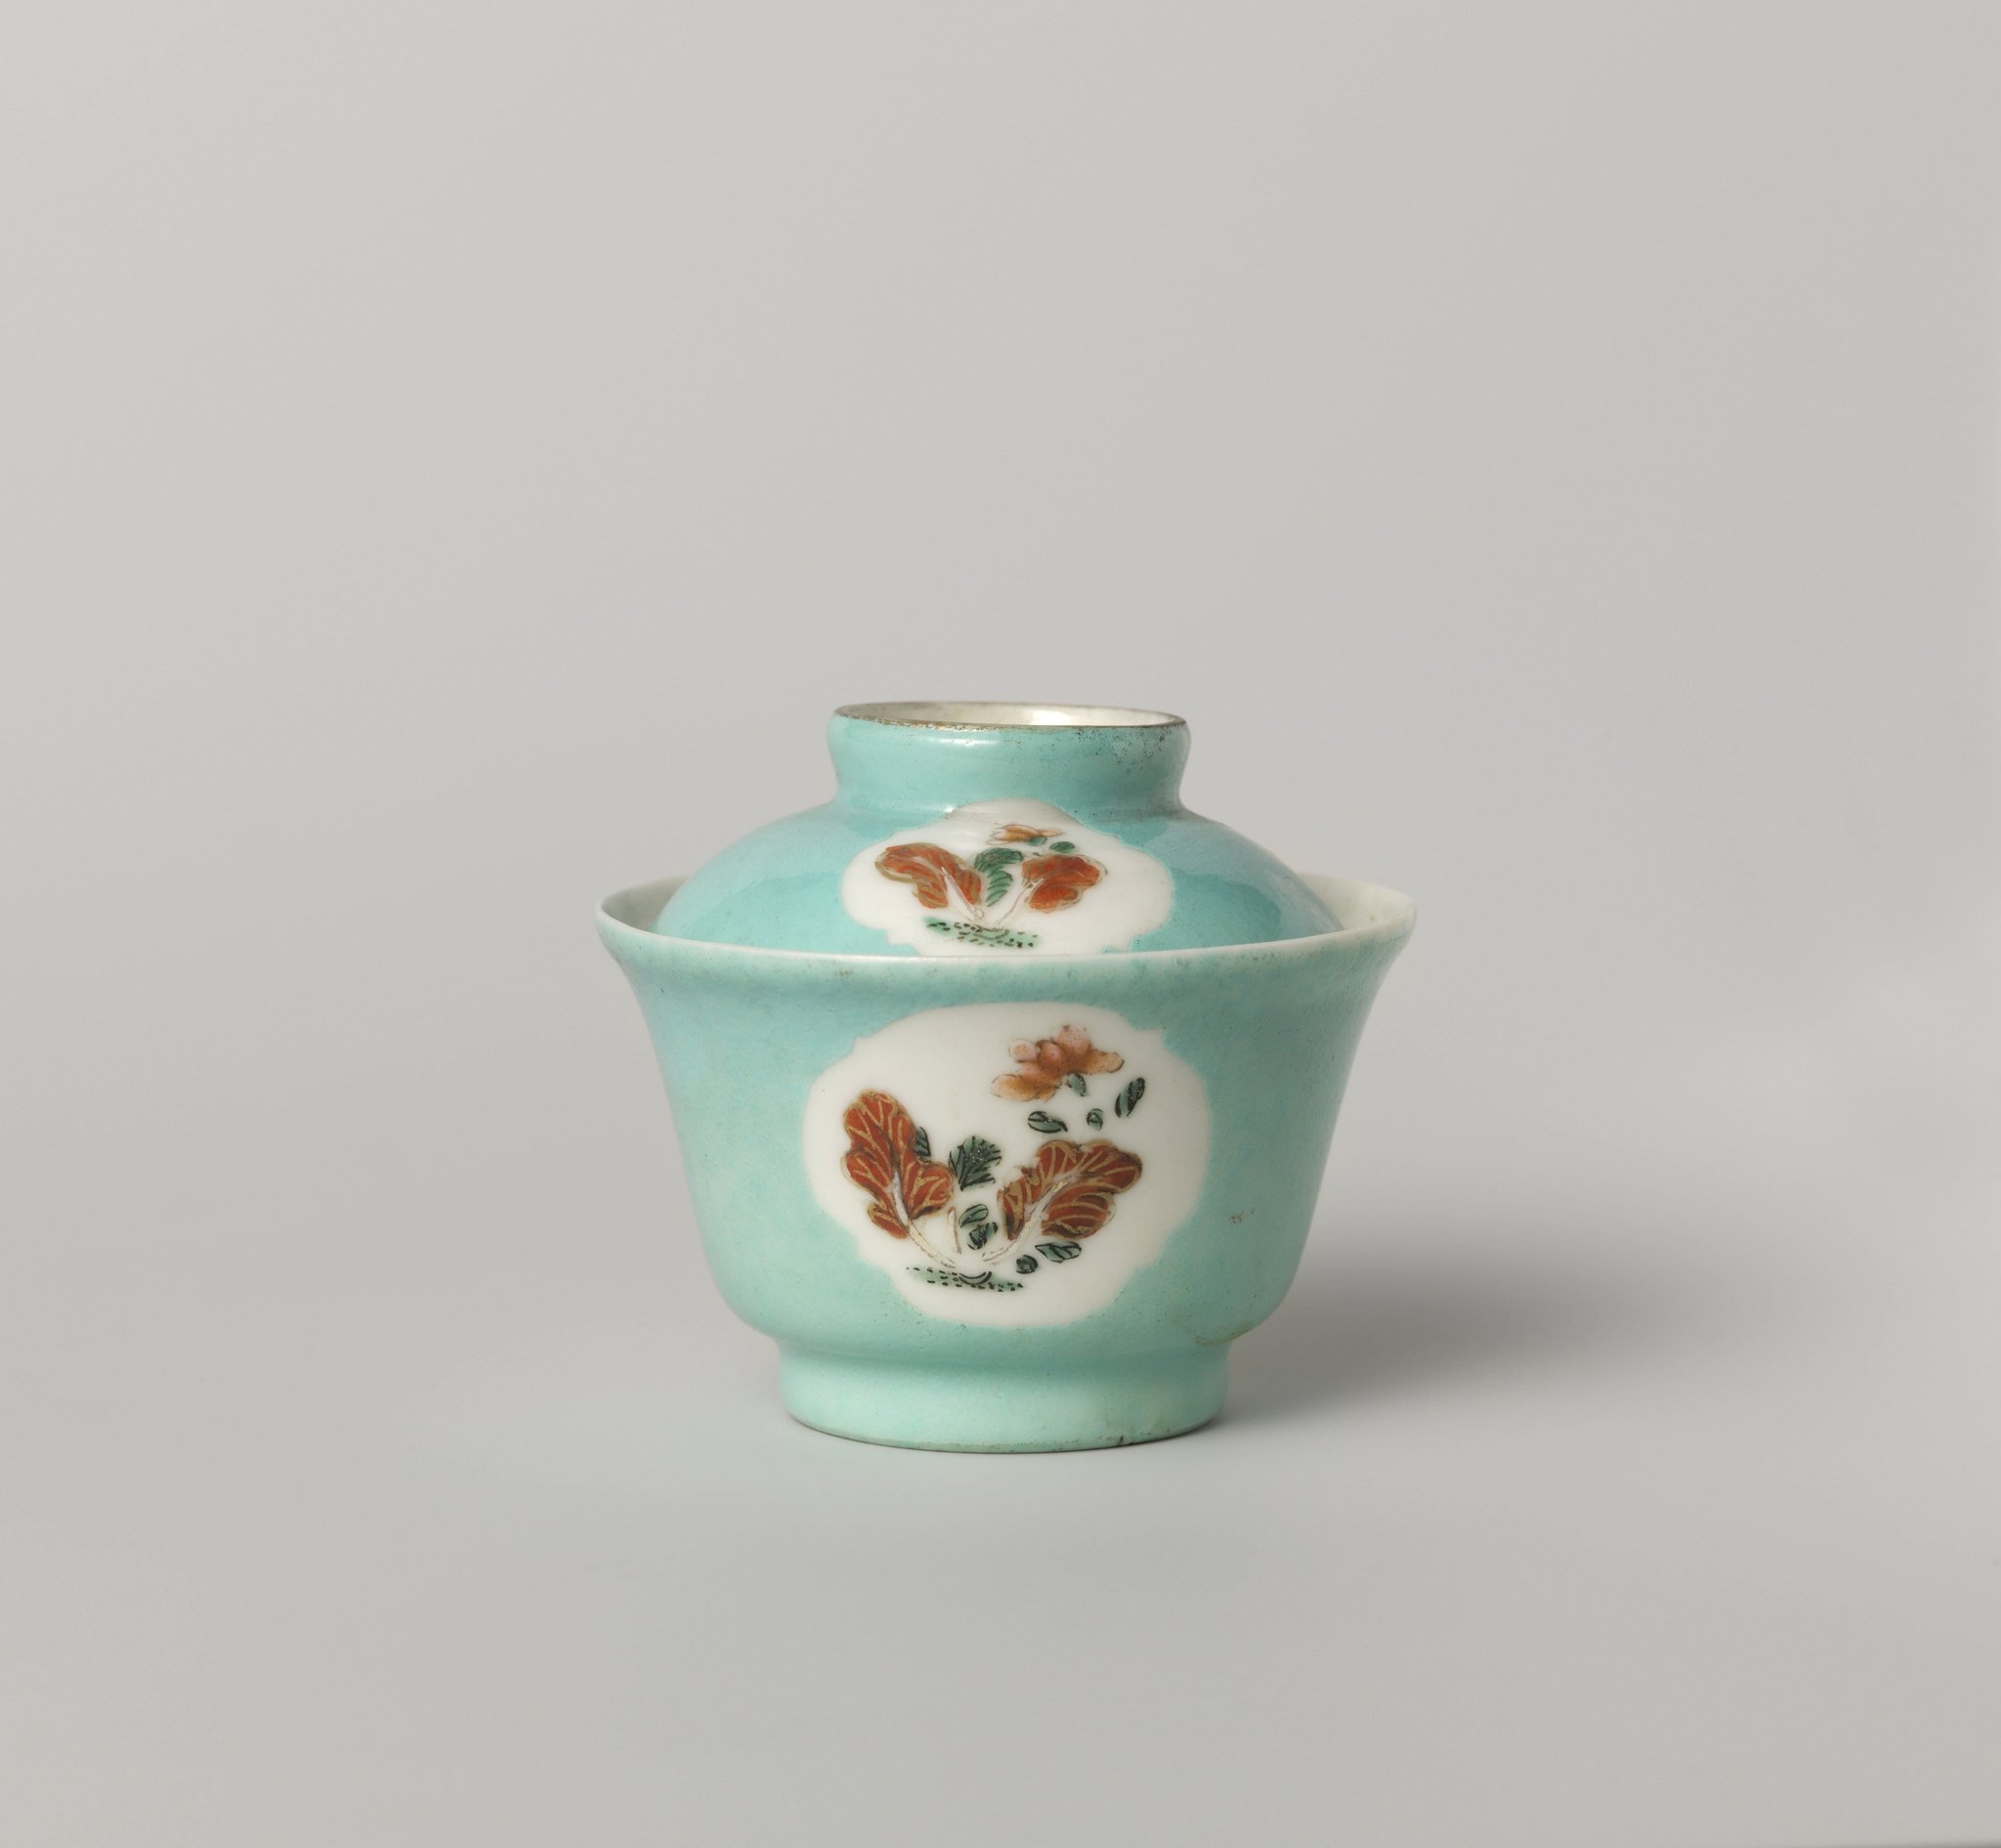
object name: kop en schotel, kop en schotel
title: Bell-shaped covered cup with flowering plants in shaped panels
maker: Anonymous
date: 1760-1780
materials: glaze, gold, paint, porcelain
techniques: firing, gilding, turning, vitrification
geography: china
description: Deksel van klokvormige kop van porselein, bedekt met een turquoise glazuur en berschilderd in blauw, rood, roze, groen, zwart en goud. Bedekt met een turquoise glazuur met hierin uitgespaard in het centrum een geschulpt medaillon met plant, daaromheen drie uitgespaarde cartouches met bloeiende planten en een vogel op een tak. Famille rose.